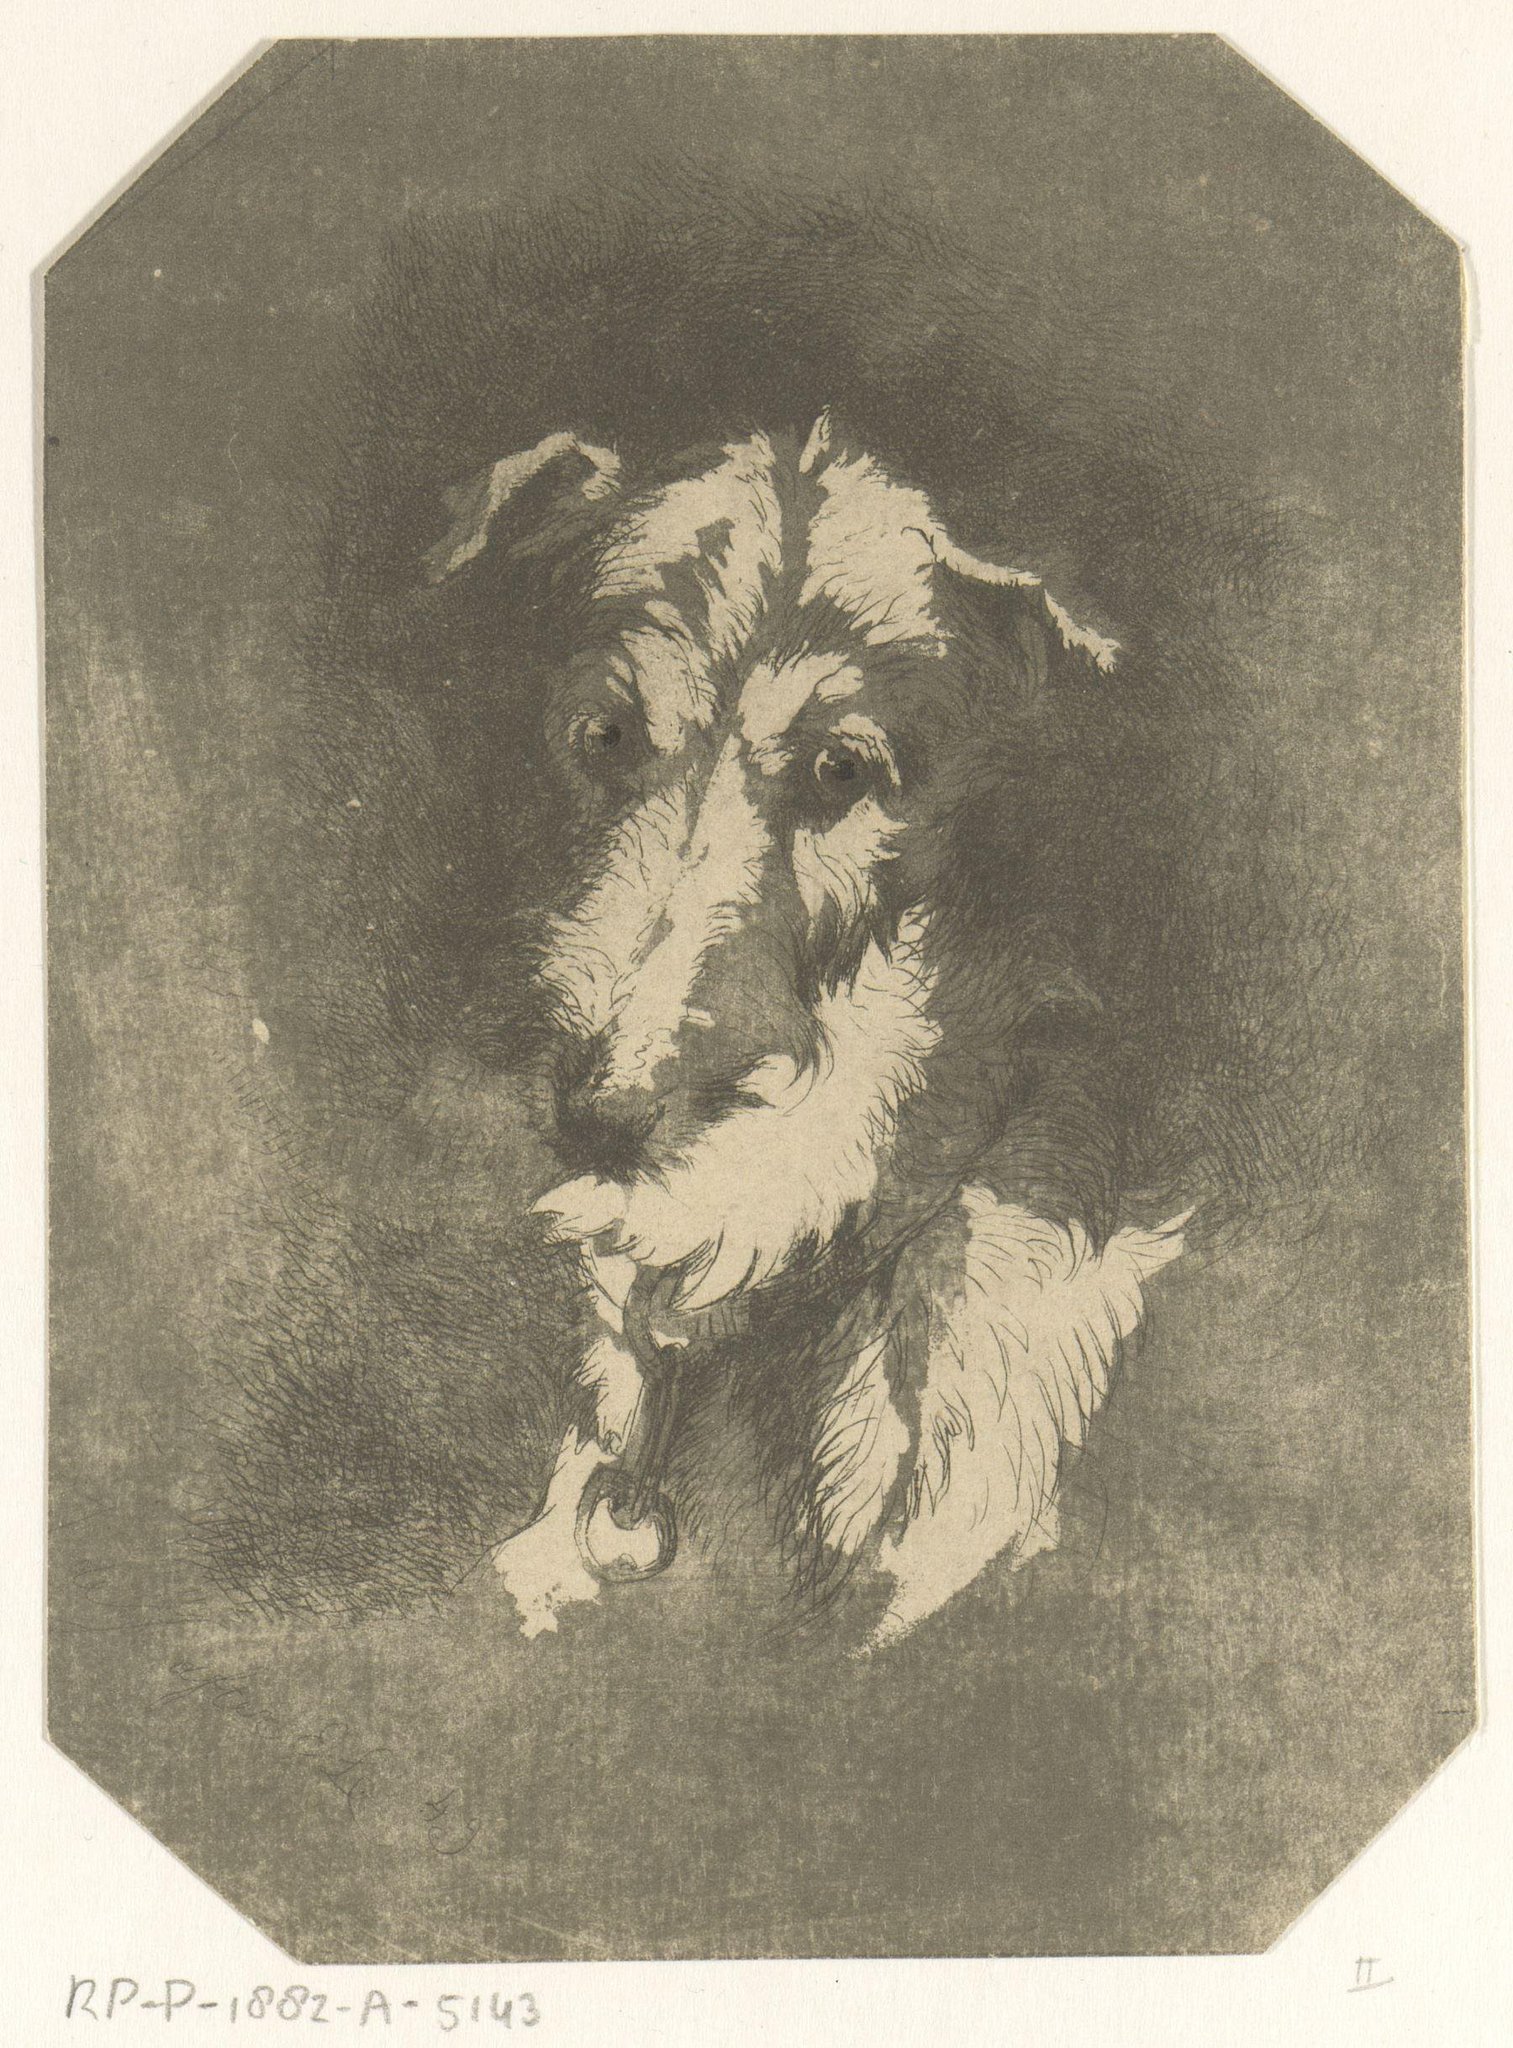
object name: print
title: Kop van hazewindhond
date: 1849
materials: paper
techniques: aquatint, etching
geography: the hague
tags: dog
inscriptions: collector's mark: Lugt 2228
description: Uit inventarisboek: Kr. 5. Verso: tekening in bruine inkt van een herbergscène en een tekening in potlood van twee vechtende mannen.